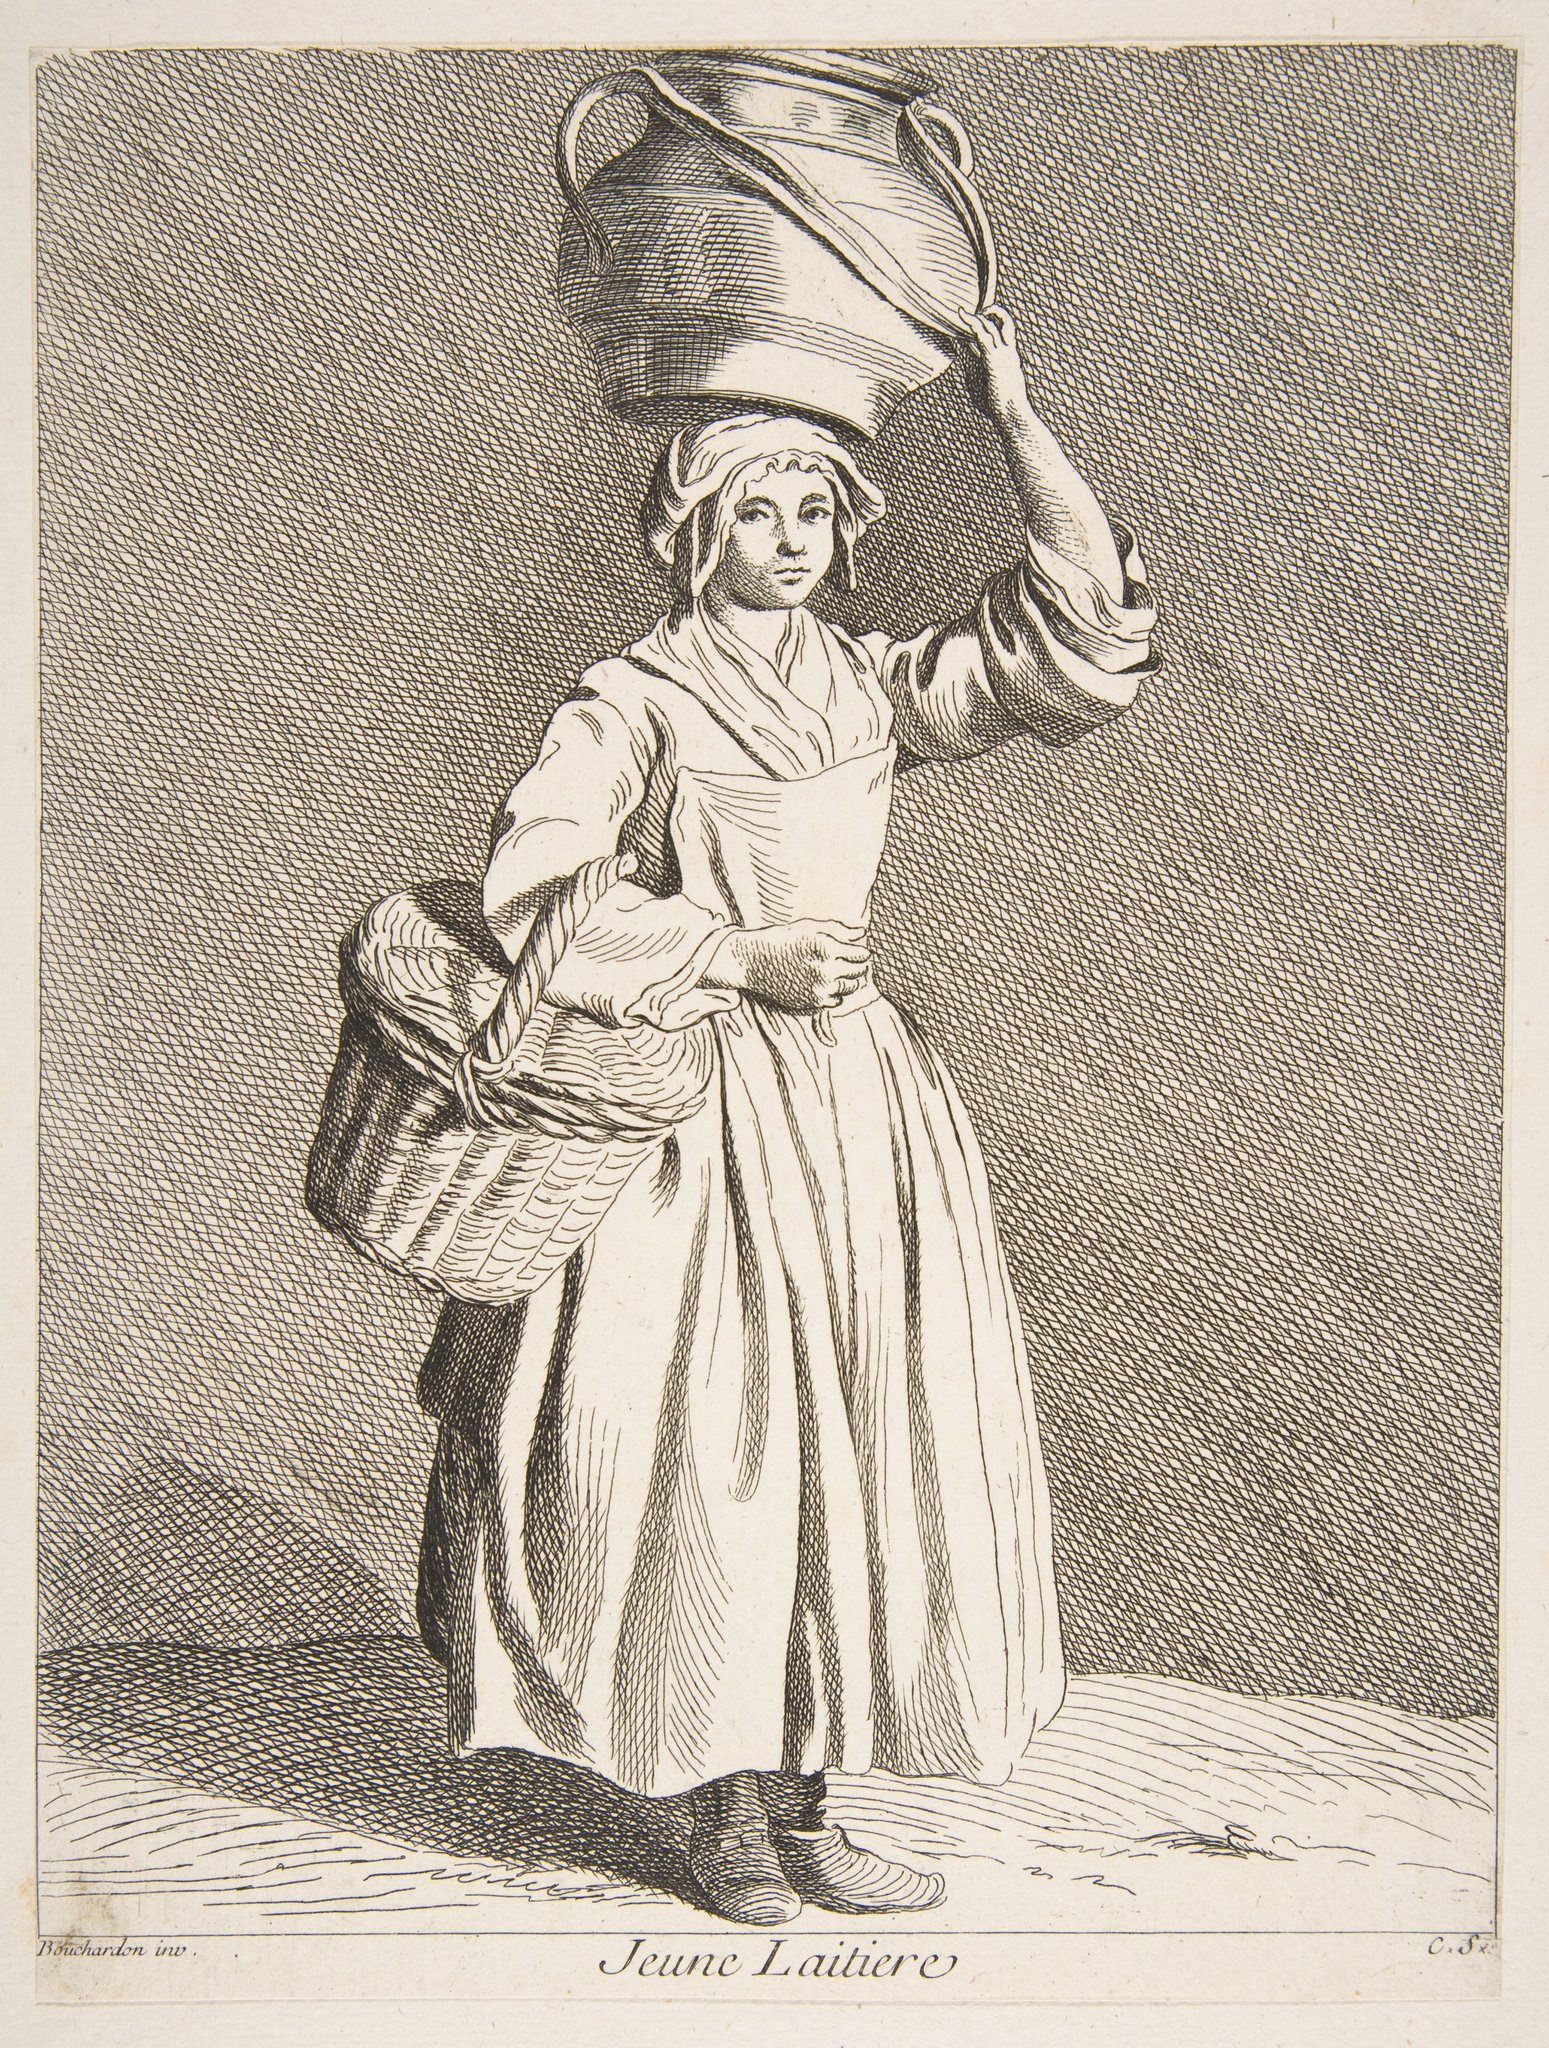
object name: print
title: Young Milkmaid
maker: anne claude philippe de tubières, comte de caylus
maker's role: artist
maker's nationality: french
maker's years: 1692-1765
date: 1737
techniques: engraving, etching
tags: women